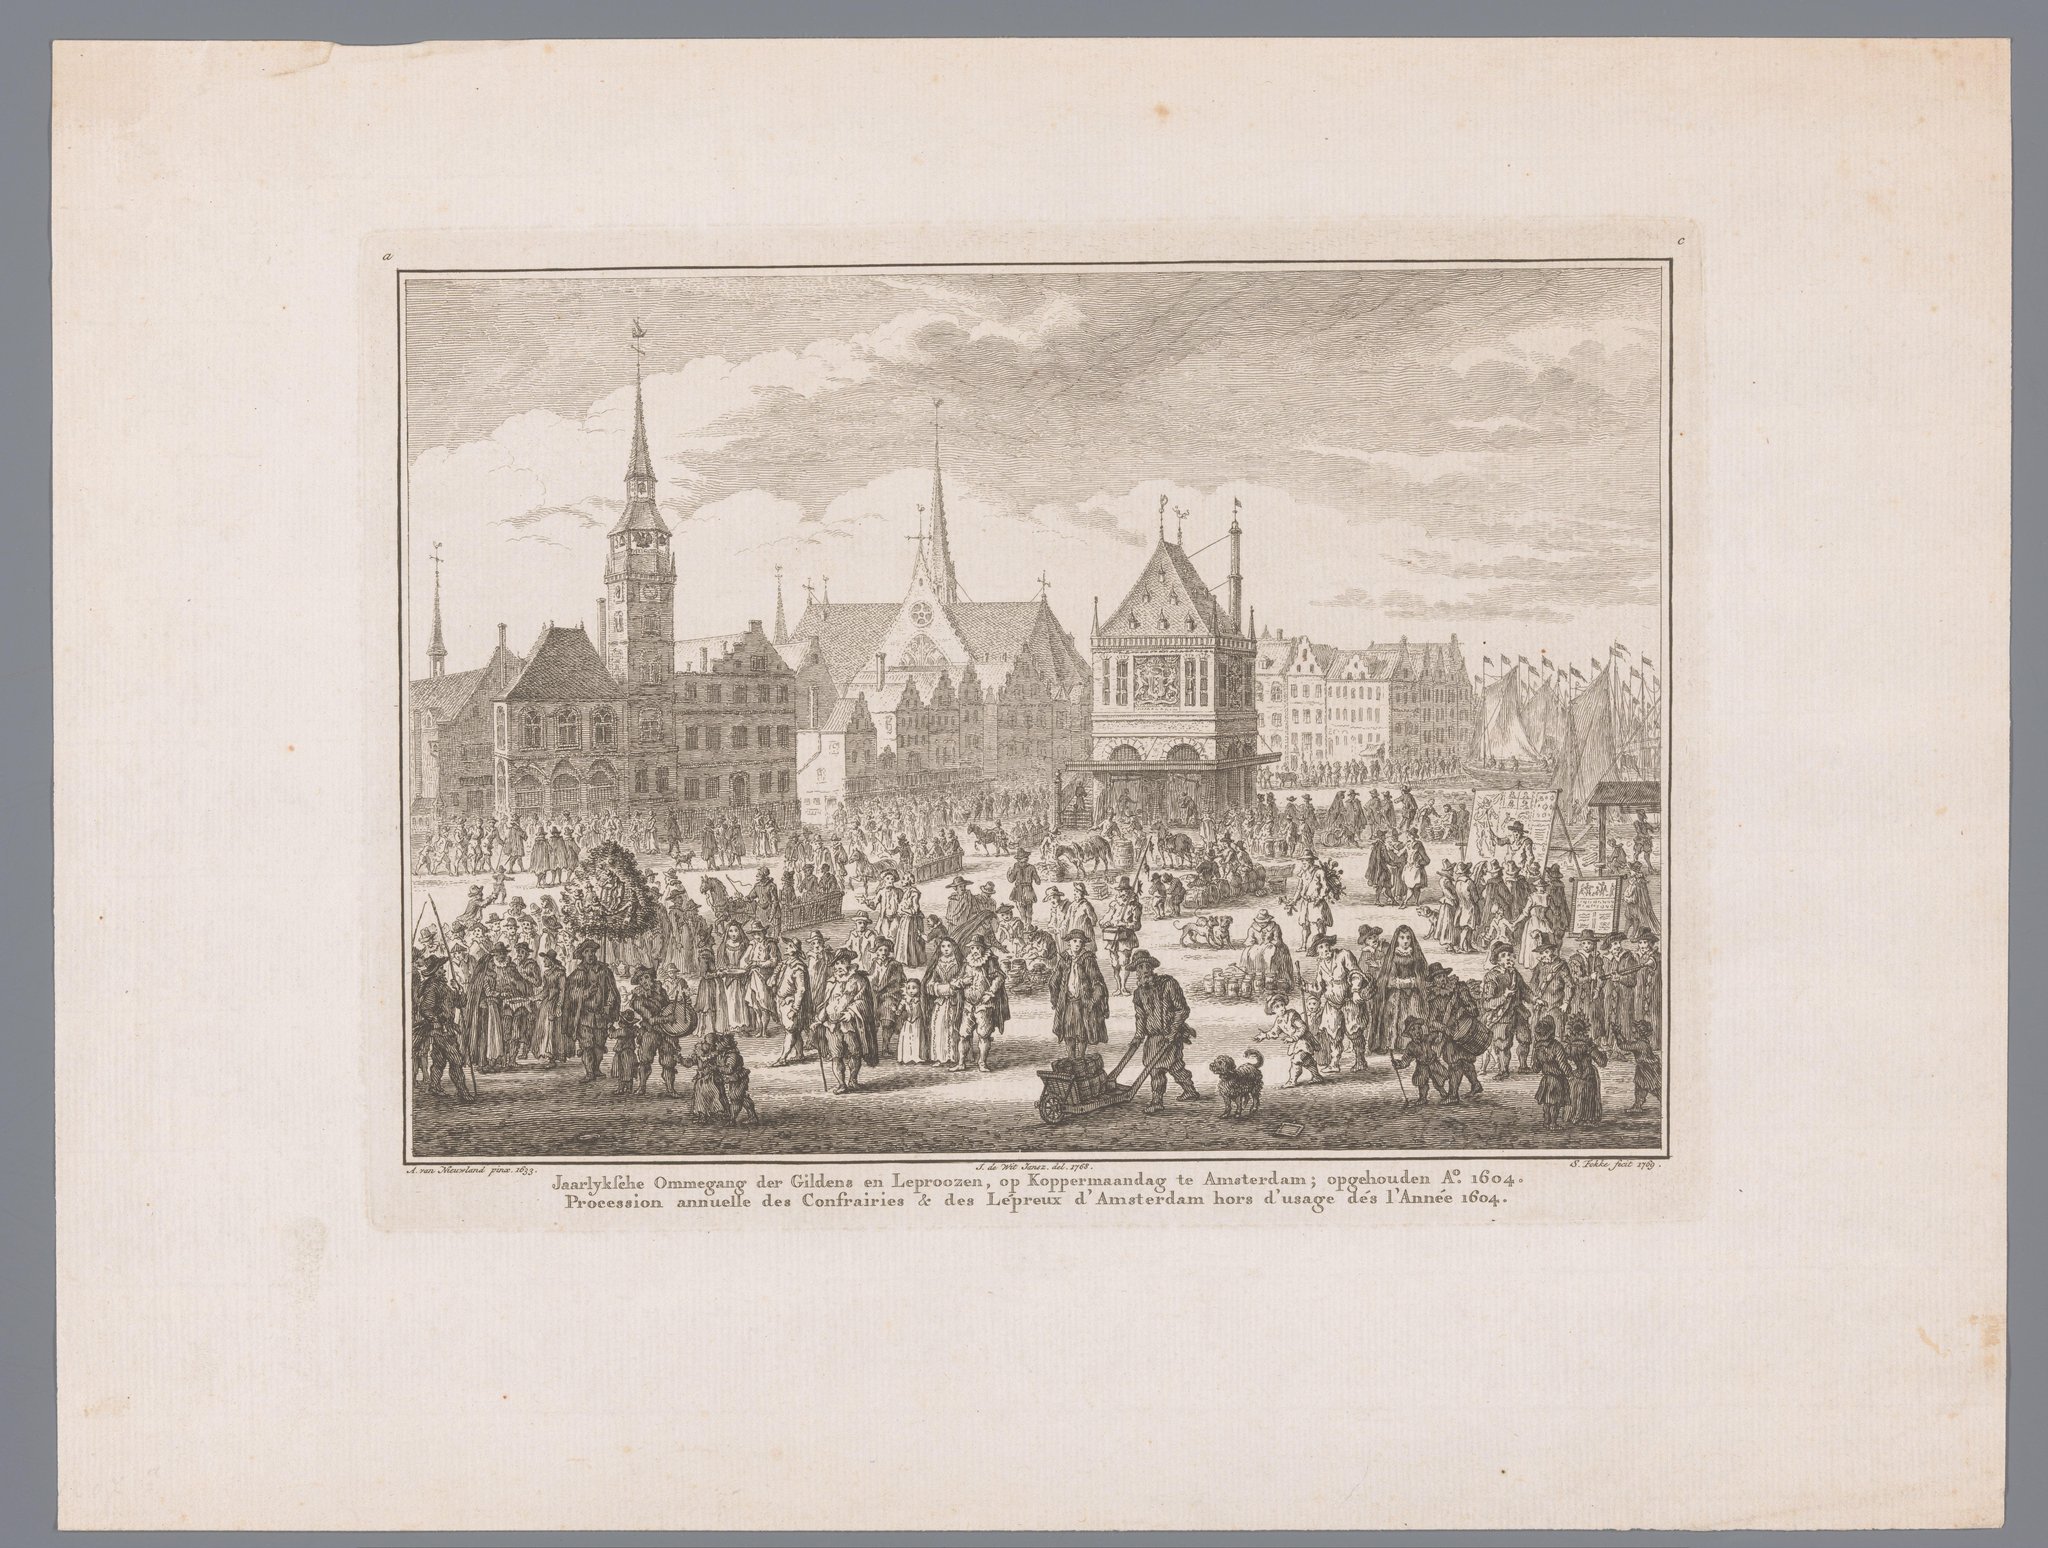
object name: print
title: Koppermaandag met leprozenoptocht te Amsterdam, 1604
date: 1769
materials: paper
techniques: etching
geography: netherlands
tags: festivities ~ corporative organization, guild, story teller; listening to story teller, leper's procession, amsterdam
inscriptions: date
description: Koppermaandag in 1604 op de Dam in Amsterdam. Op de voorgrond de processie van de gilden en melaatsen. Rechts een verhalenverteller bij een bord met afbeeldingen. De prent is links- en rechtsboven gemerkt, respectievelijk met de letters a en c.